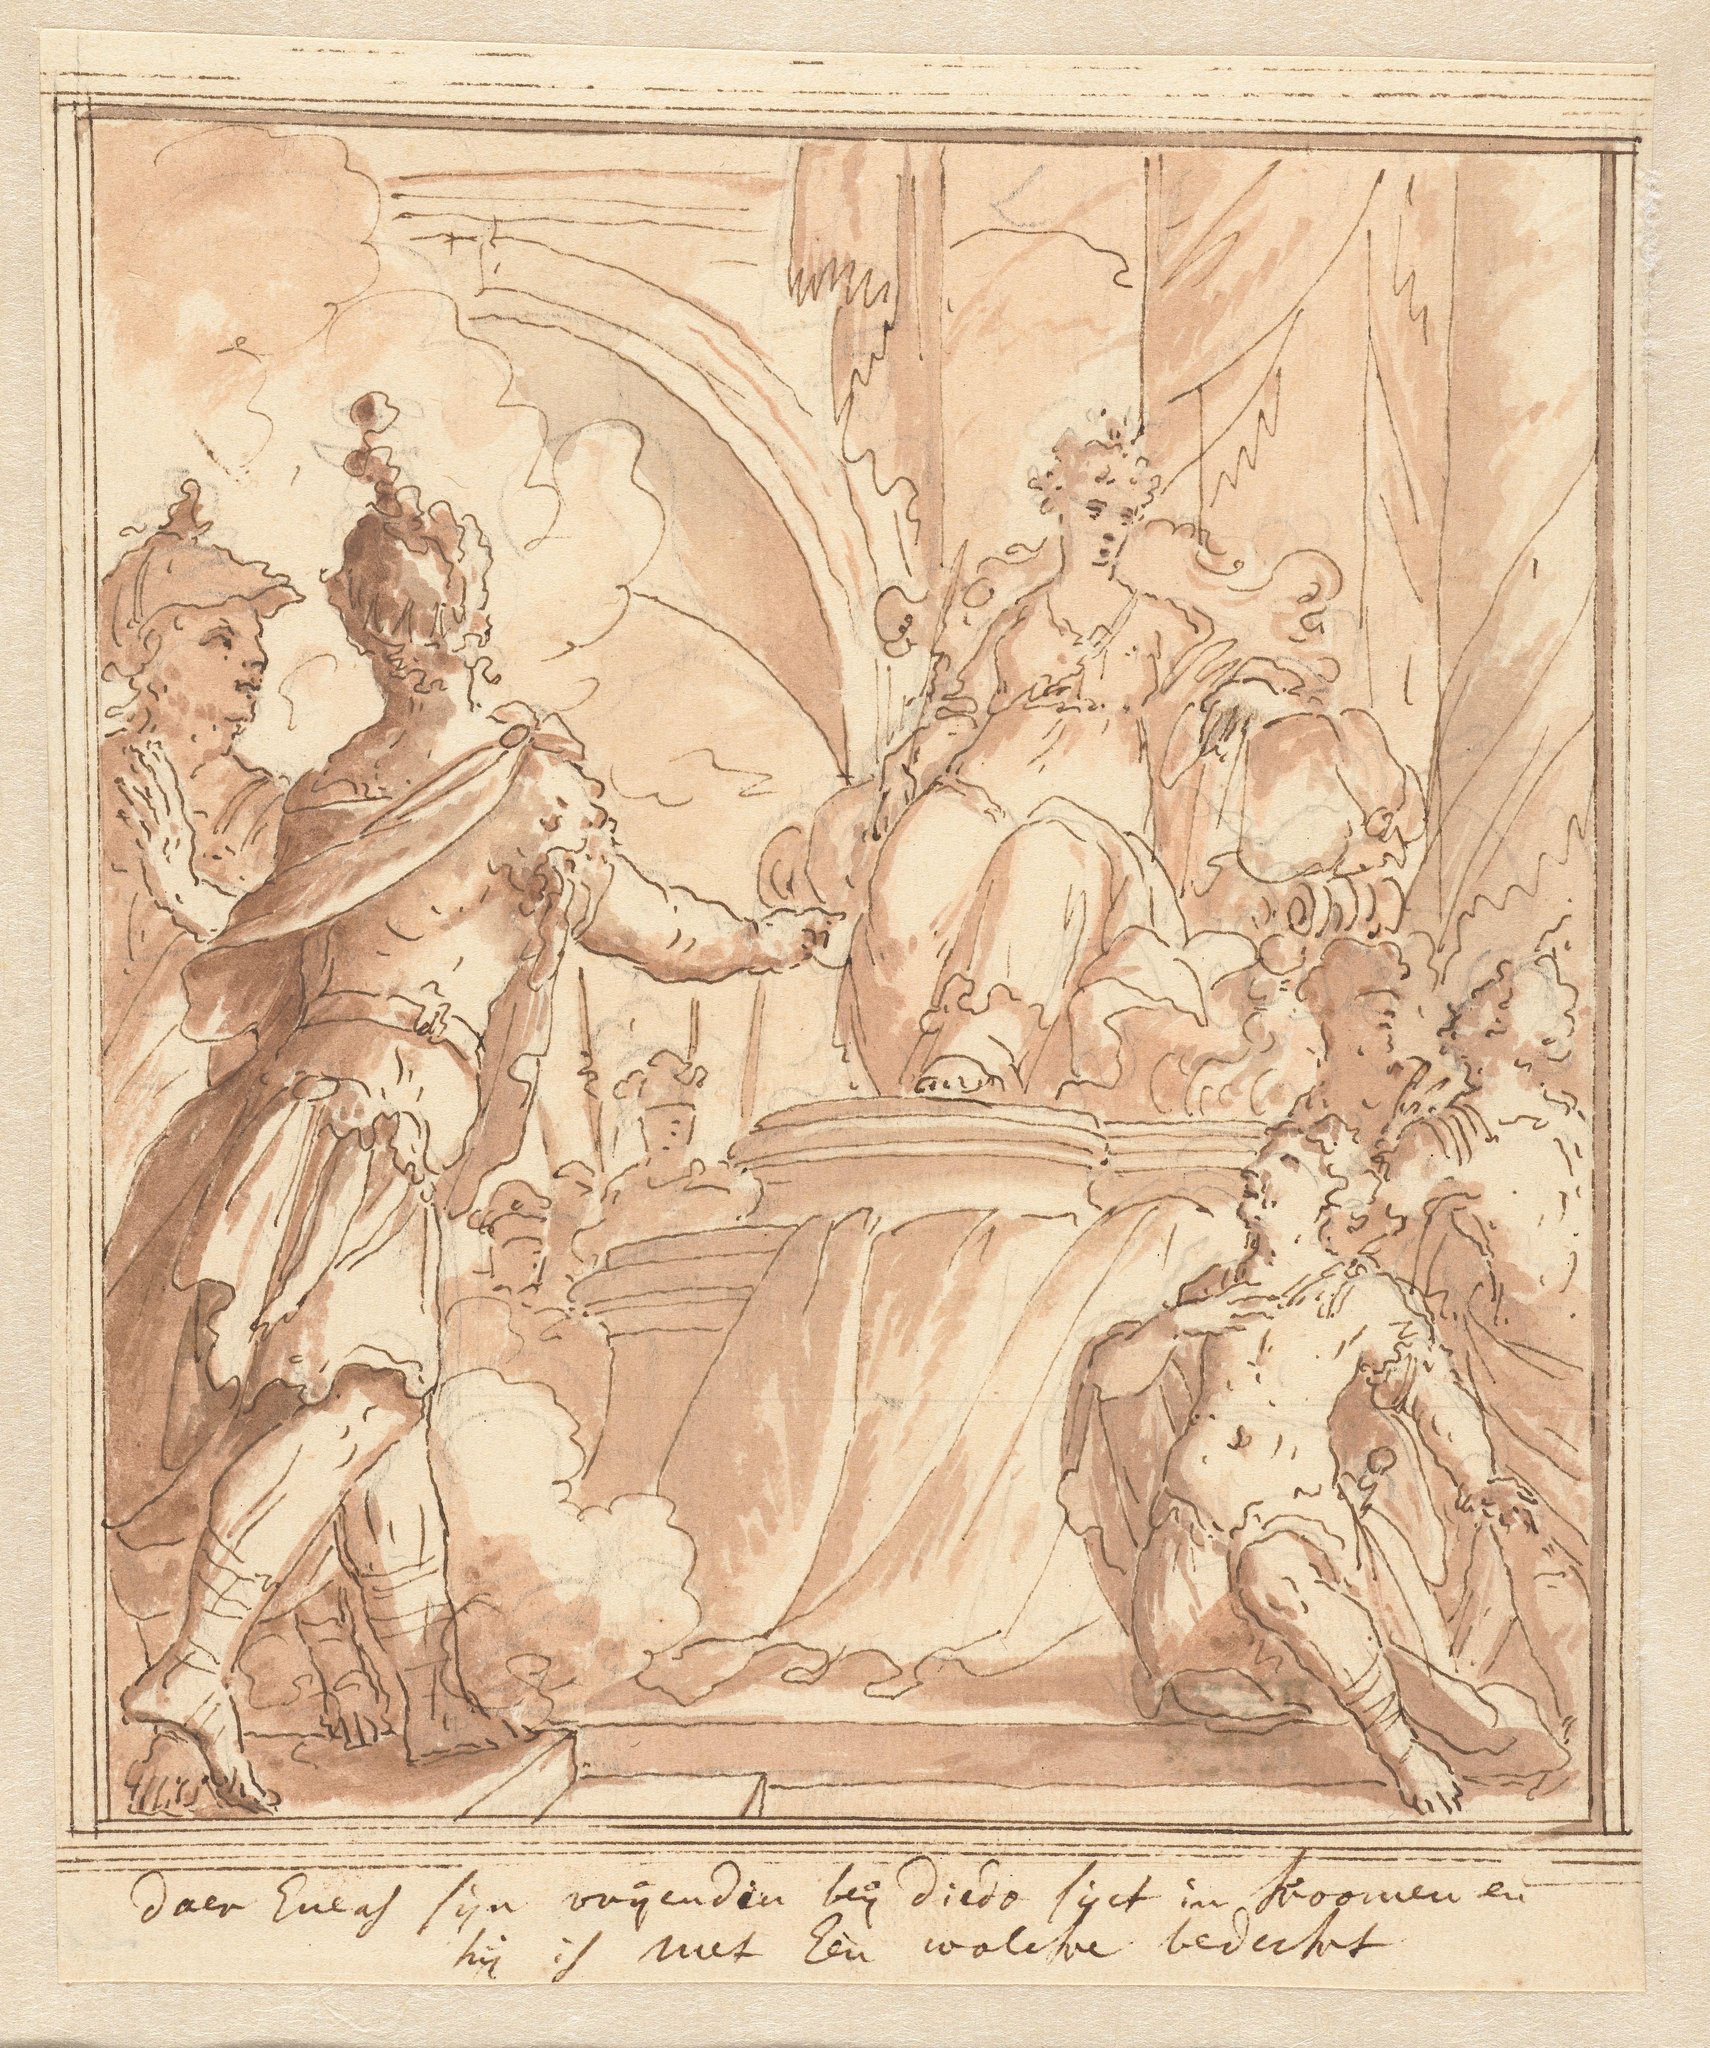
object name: drawing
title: Ontwerpen voor schilderijen met episodes uit De Aeneas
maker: mattheus terwesten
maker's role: draughtsman, painter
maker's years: 1670-1757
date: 1600-1604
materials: graphite, ink, paper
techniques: brush, pen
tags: dido appears in the temple of juno; a trojan deputation asks her permission to beach and repair the ships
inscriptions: : ‘daer Eneas sijn vrijenden bij diedo sijet inkoomen en hij is met een wolcke bedeckt’